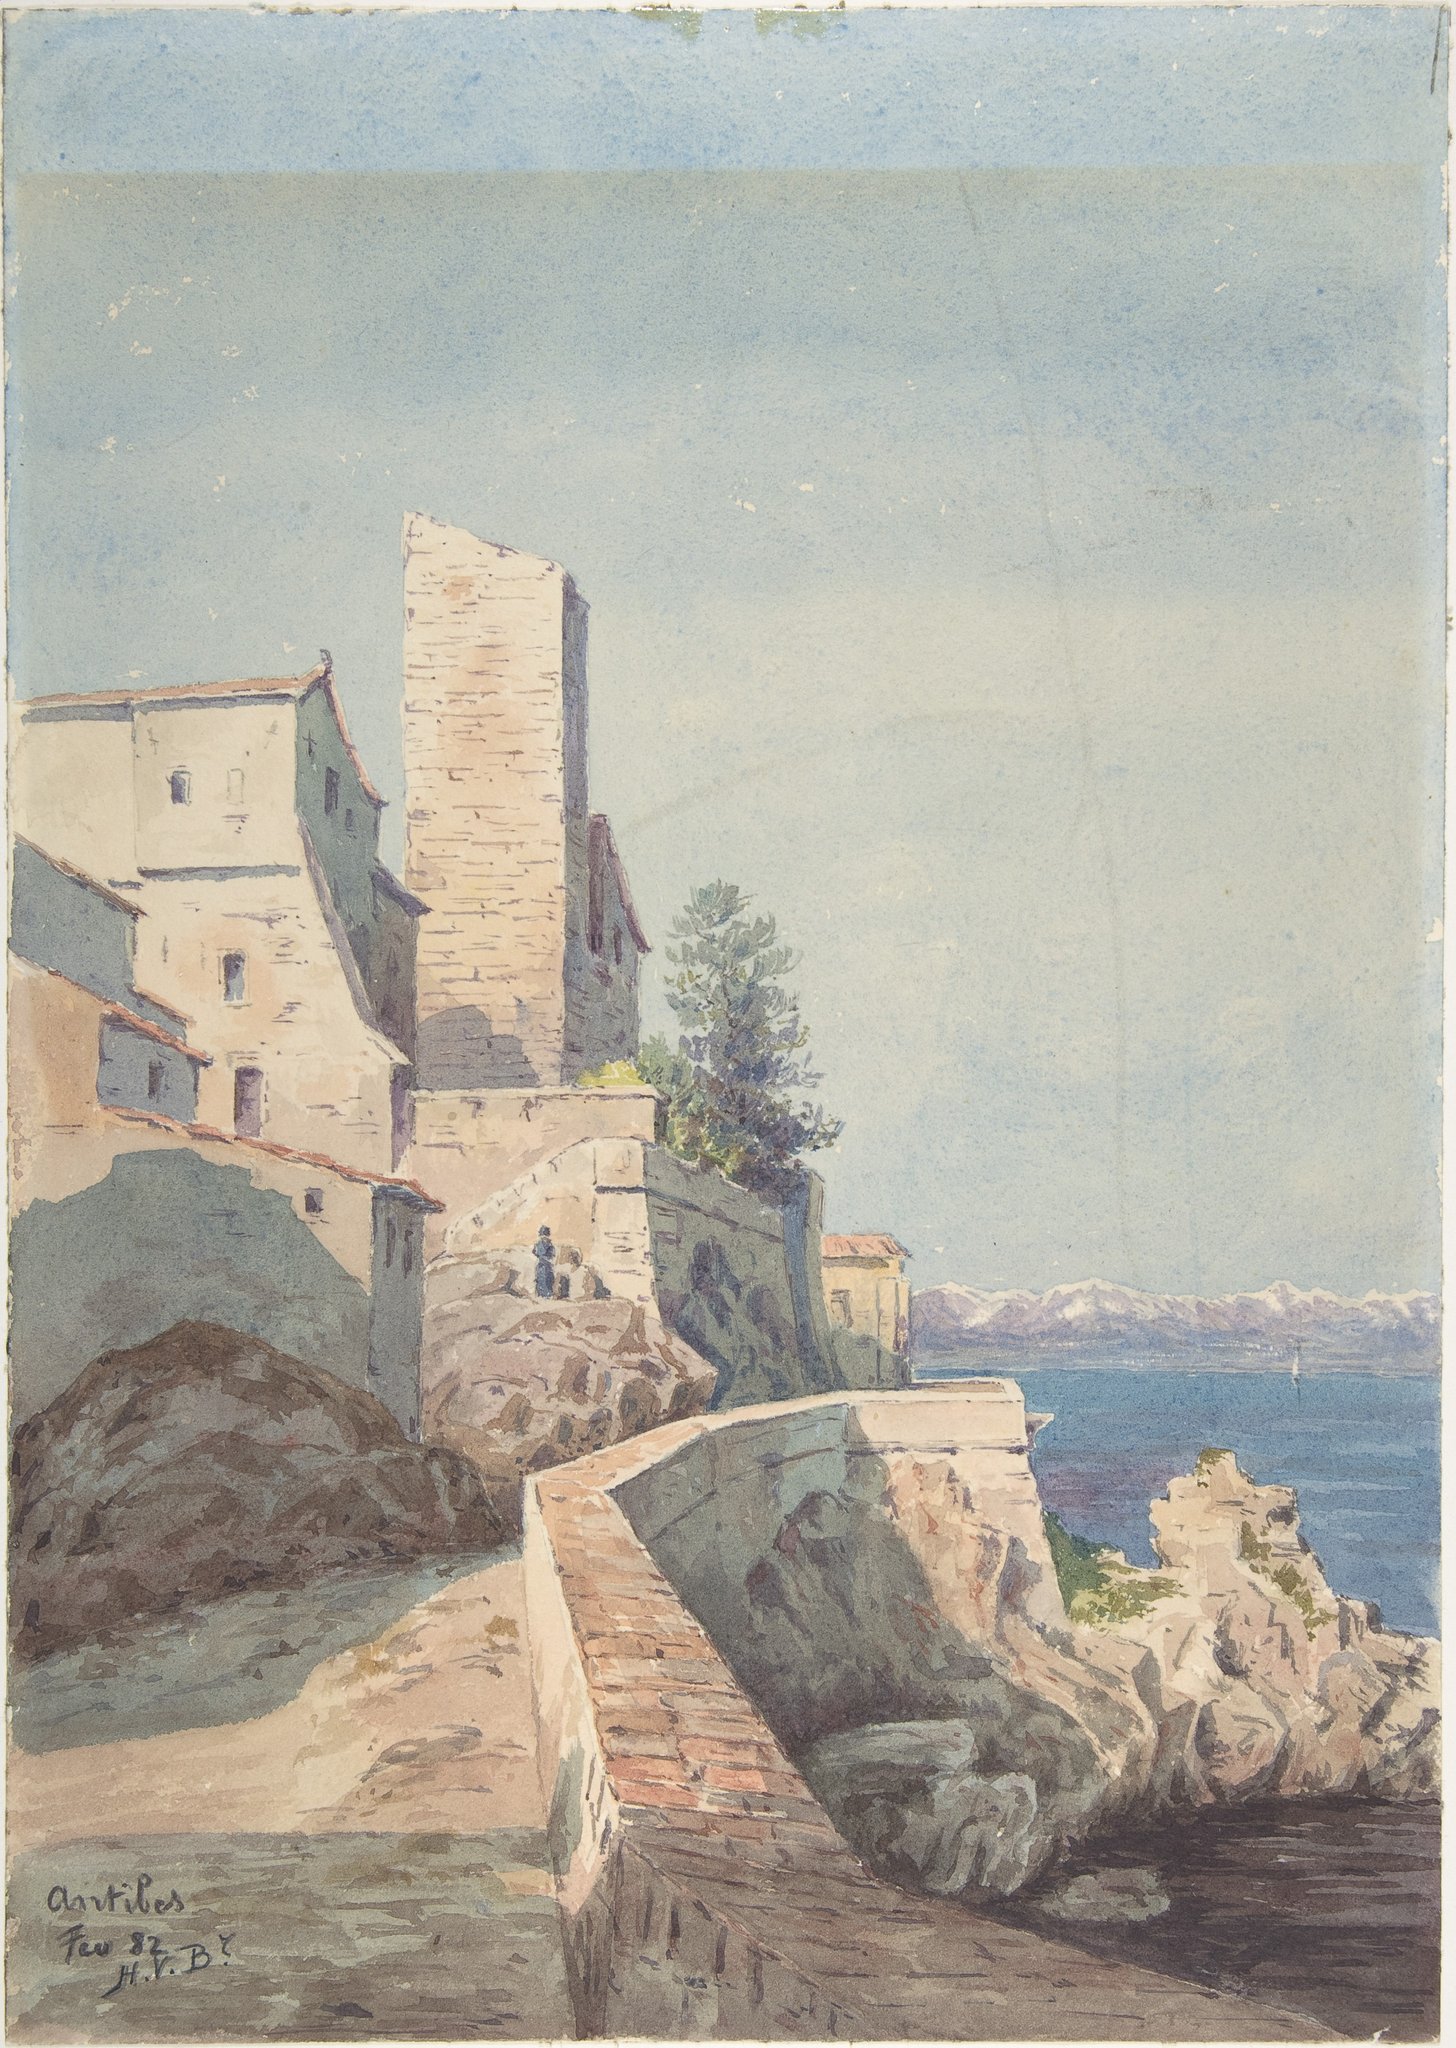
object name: drawing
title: Antibes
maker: henry victor burgy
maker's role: artist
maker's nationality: french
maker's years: 1801-1901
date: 1882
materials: watercolor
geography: france